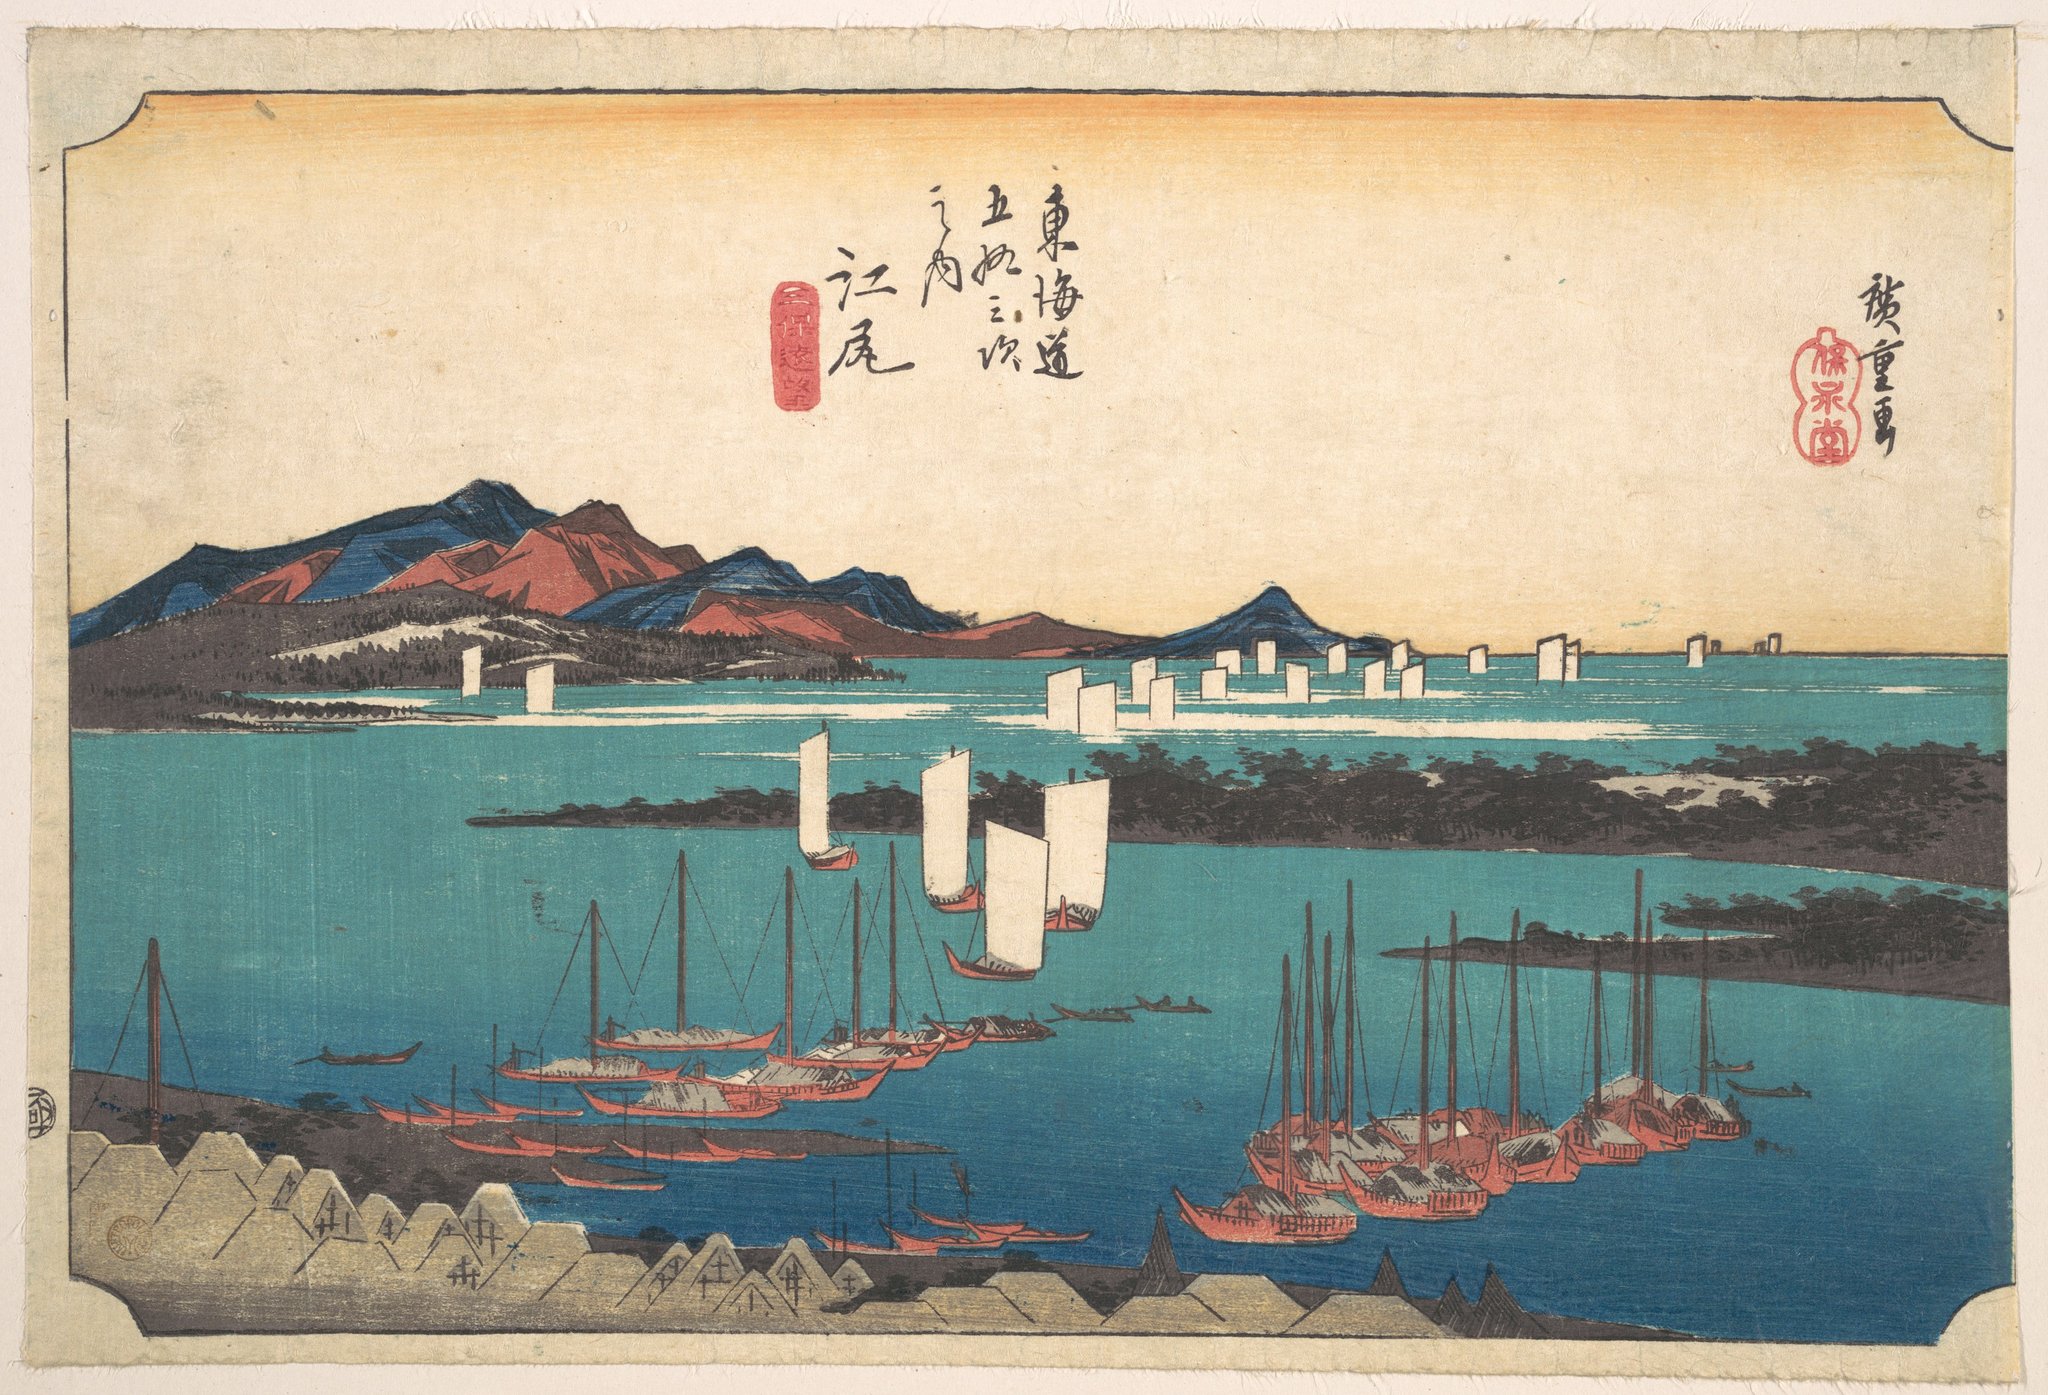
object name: print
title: Distant View of Miho Beach from Ejiri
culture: japanese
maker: utagawa hiroshige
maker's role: artist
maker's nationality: japanese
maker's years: 1797-1858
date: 1834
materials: ink, paper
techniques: woodblock print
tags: mountains,boats